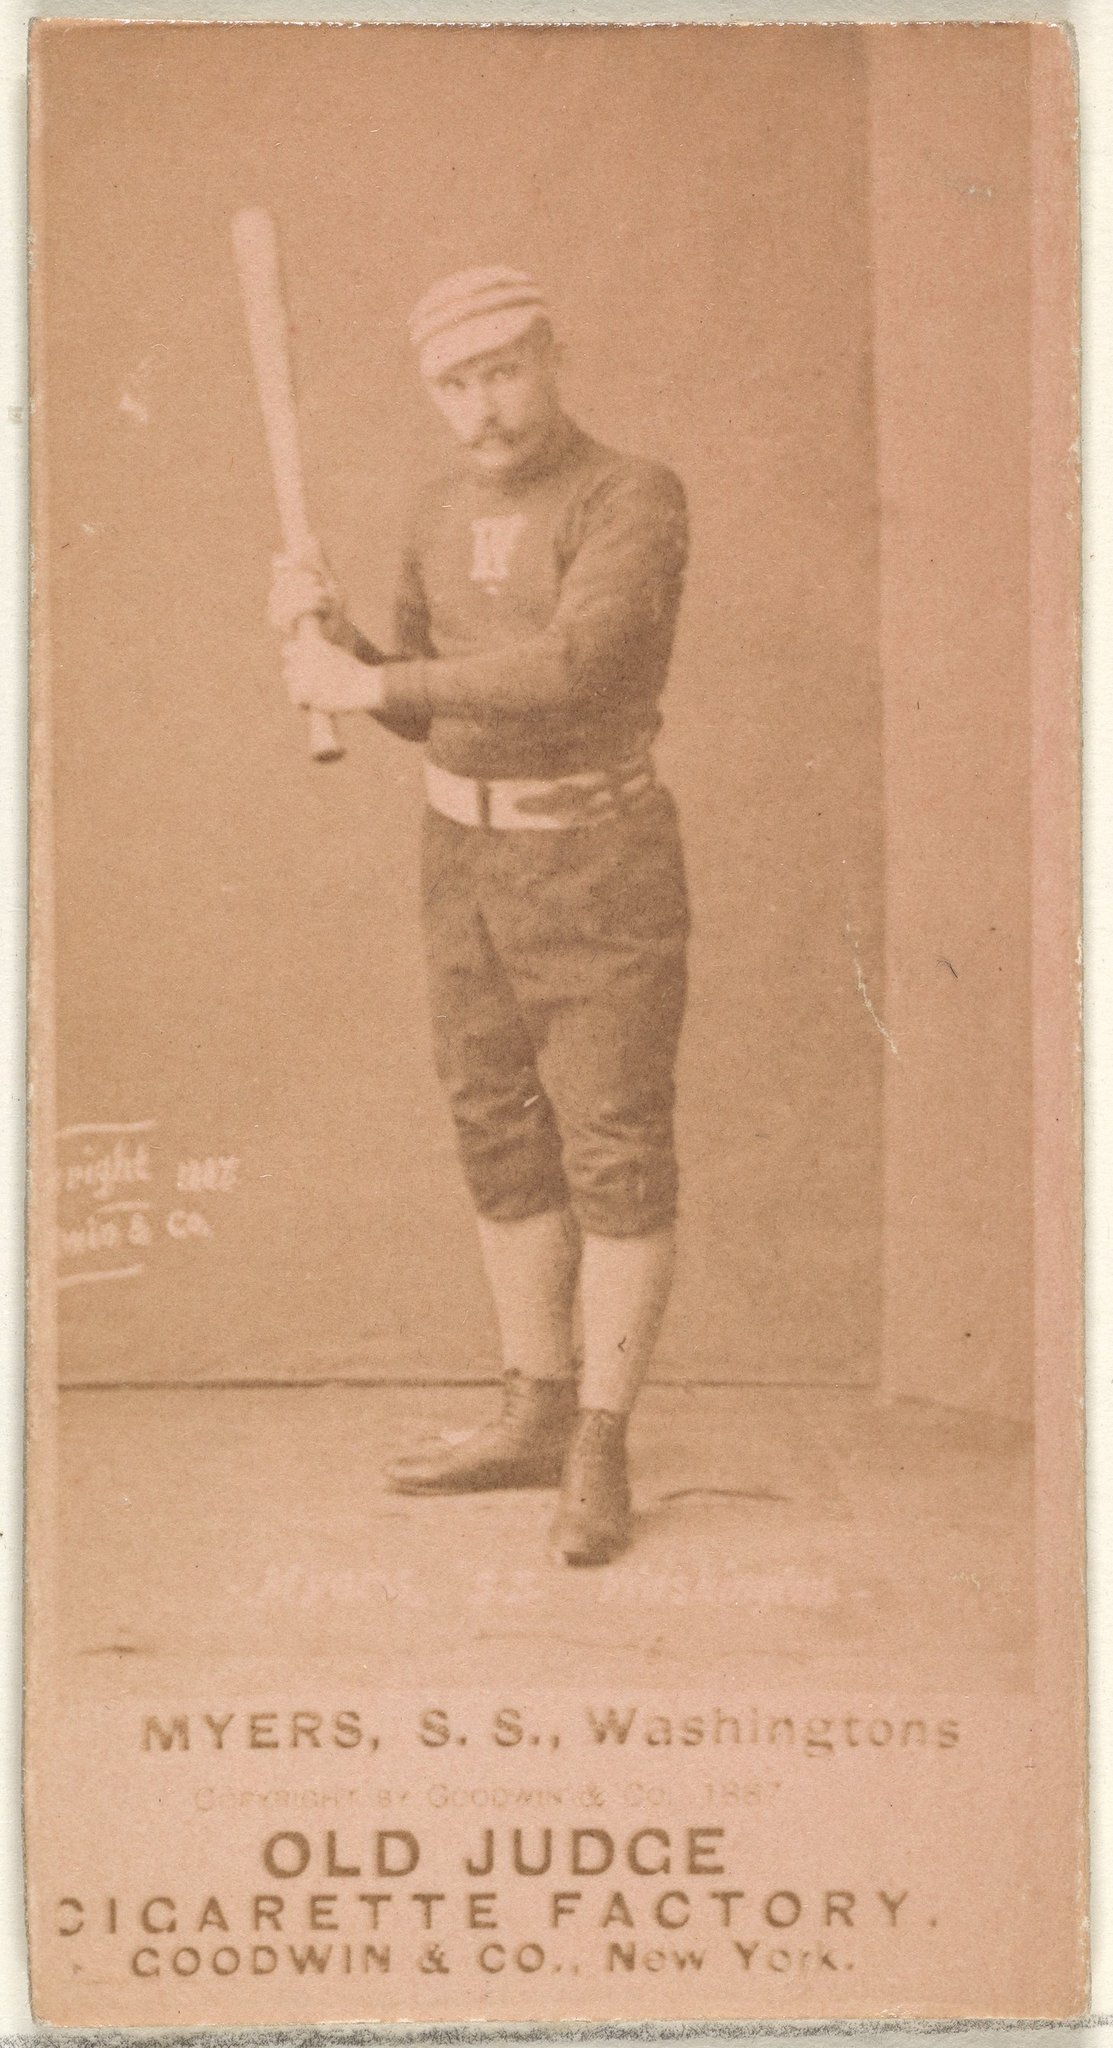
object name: baseball card, photograph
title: James Albert "Al" Myers, Shortstop, Washington Nationals, from the Old Judge series (N172) for Old Judge Cigarettes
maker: goodwin & company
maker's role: publisher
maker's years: 1850-1950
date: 1887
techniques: albumen silver print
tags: men,portraits,baseball,athletes